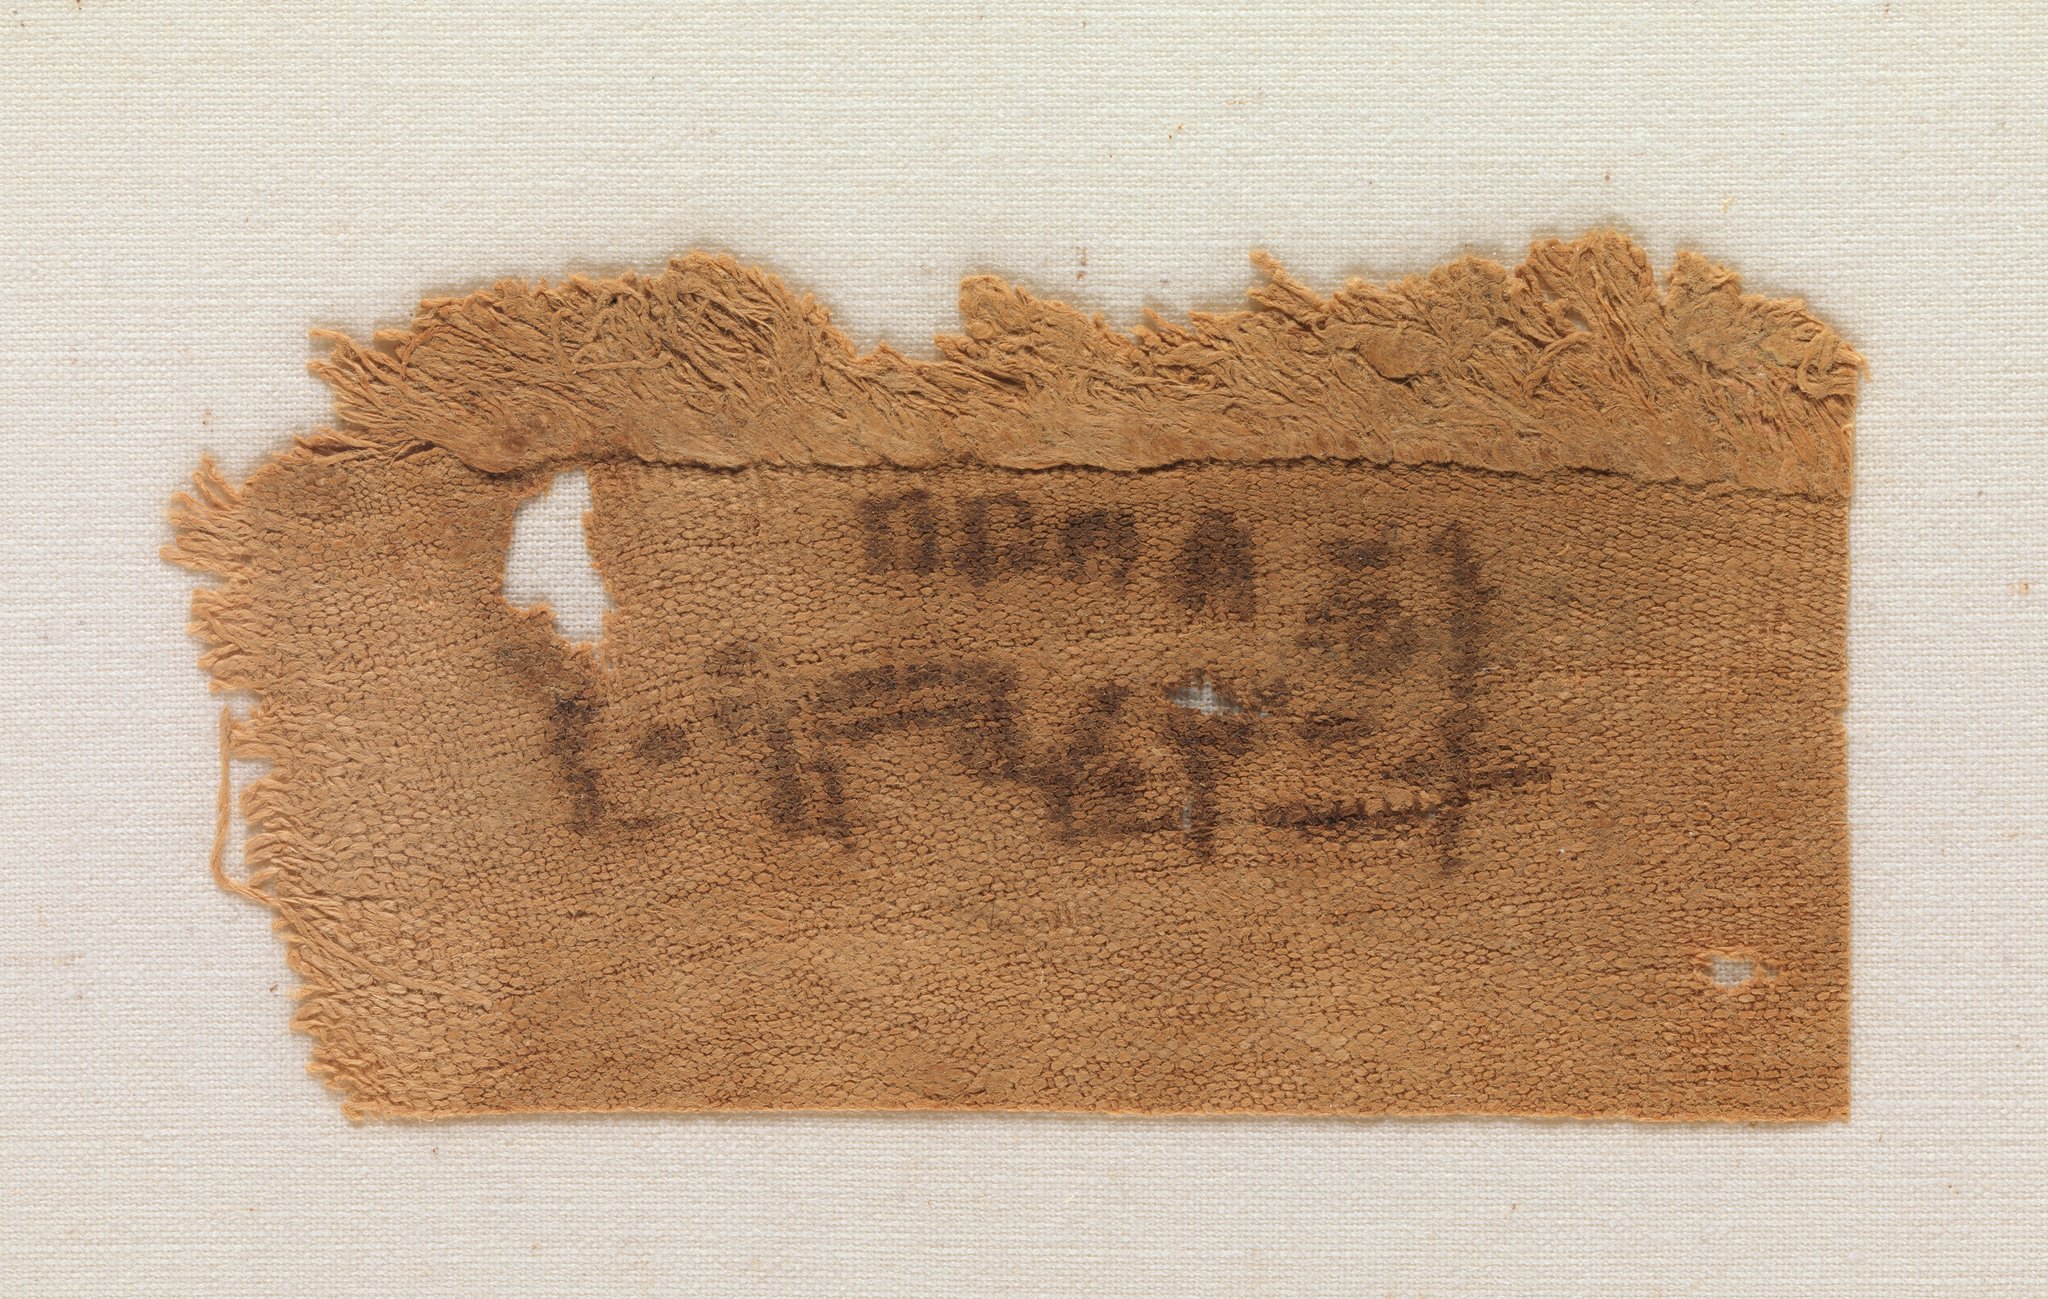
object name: linen mark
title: Linen Mark on the Corner of a Sheet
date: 2030-1640 BCE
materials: ink, linen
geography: egypt